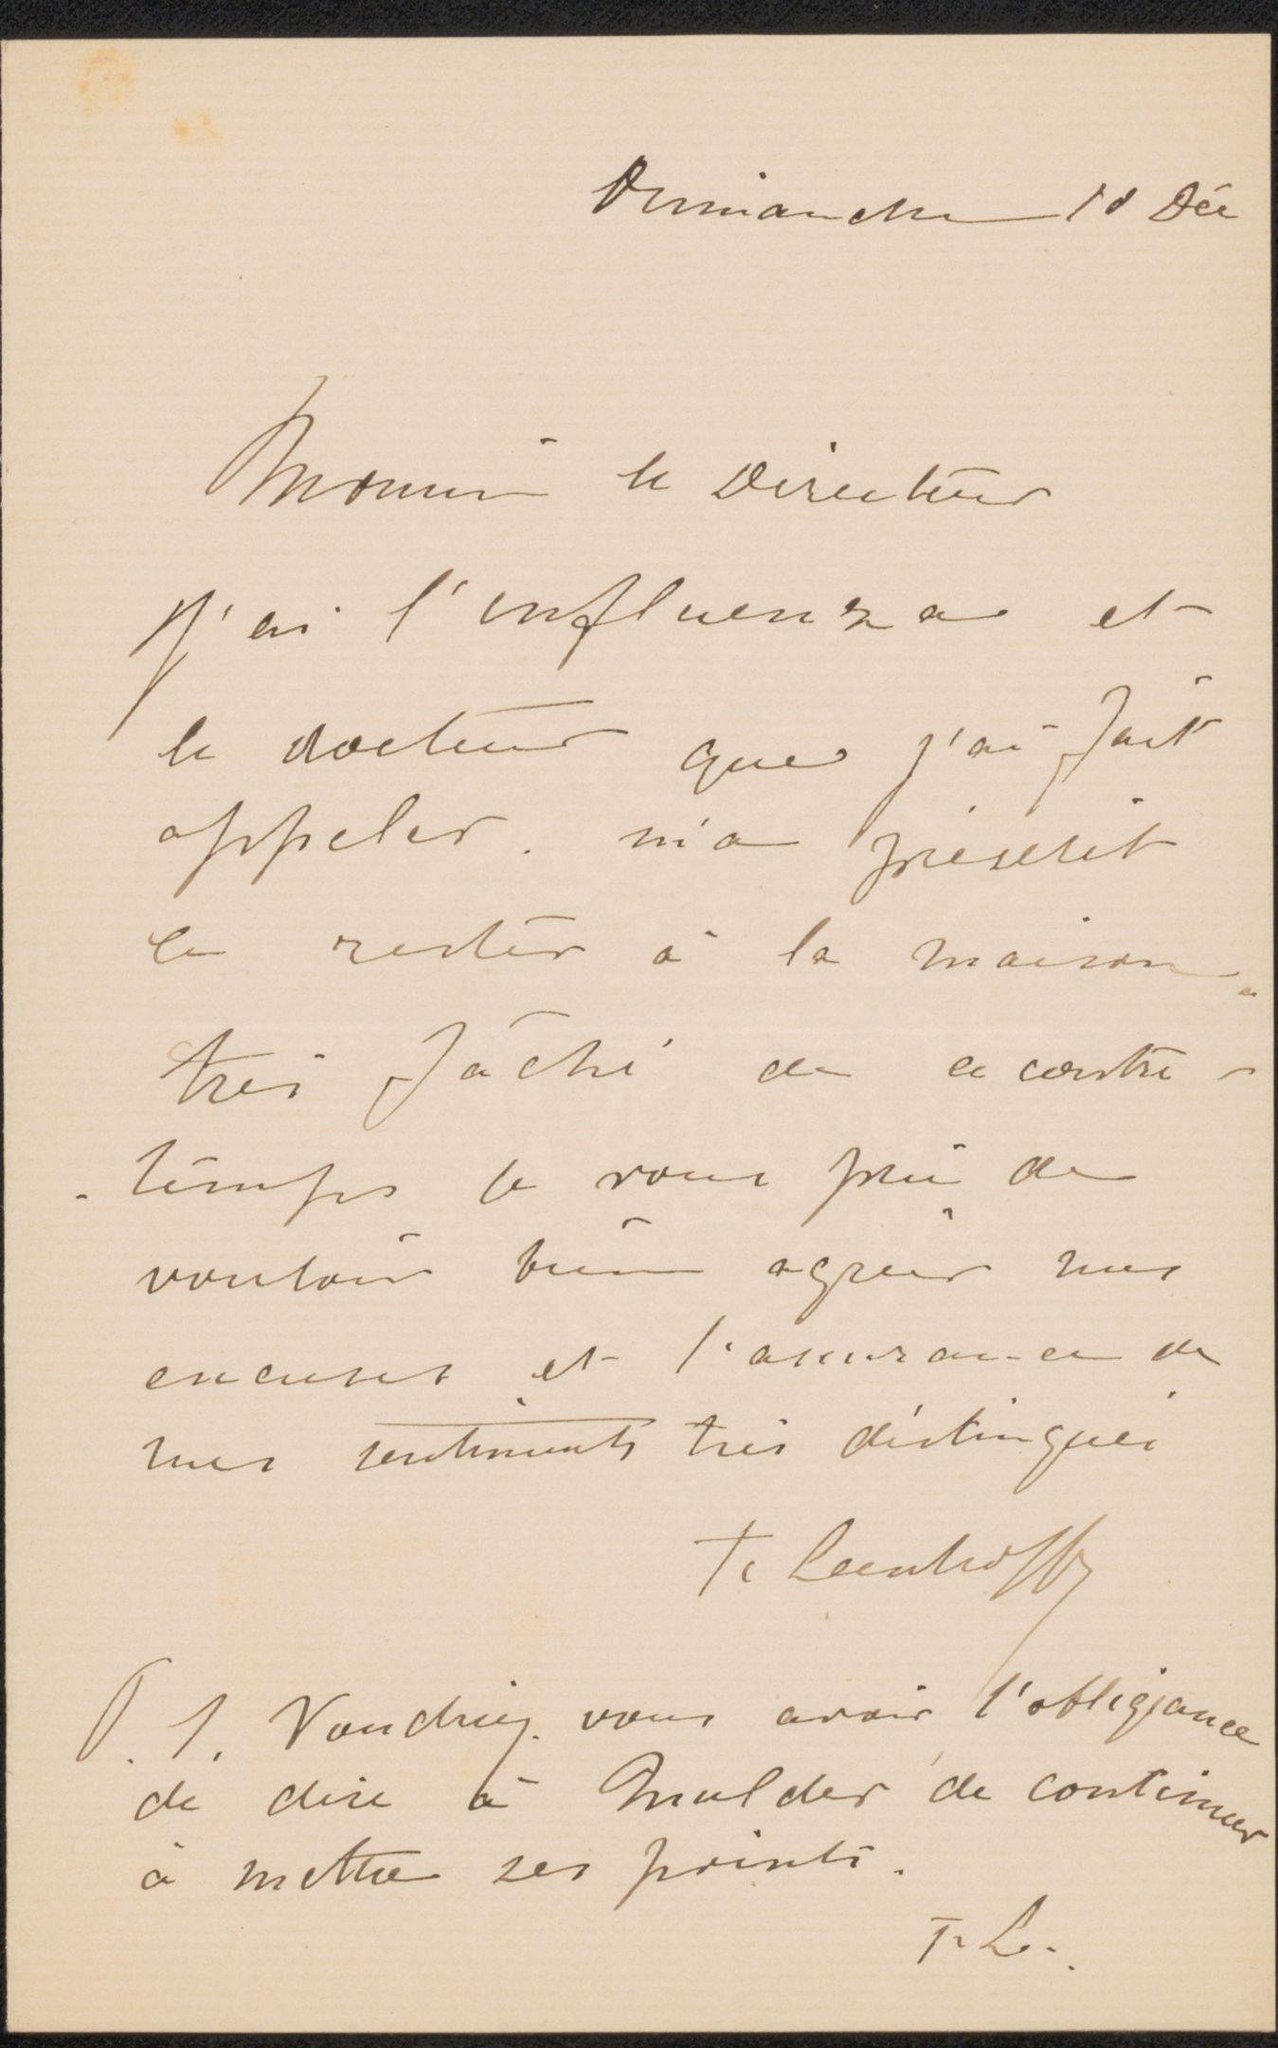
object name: letter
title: Brief aan August Allebé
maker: ferdinand leenhoff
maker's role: print maker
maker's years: 1841-1914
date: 1851-1914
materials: ink, paper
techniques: pen, writing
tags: amsterdam, print maker, draughtsman, august allebé, diseases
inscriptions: watermark